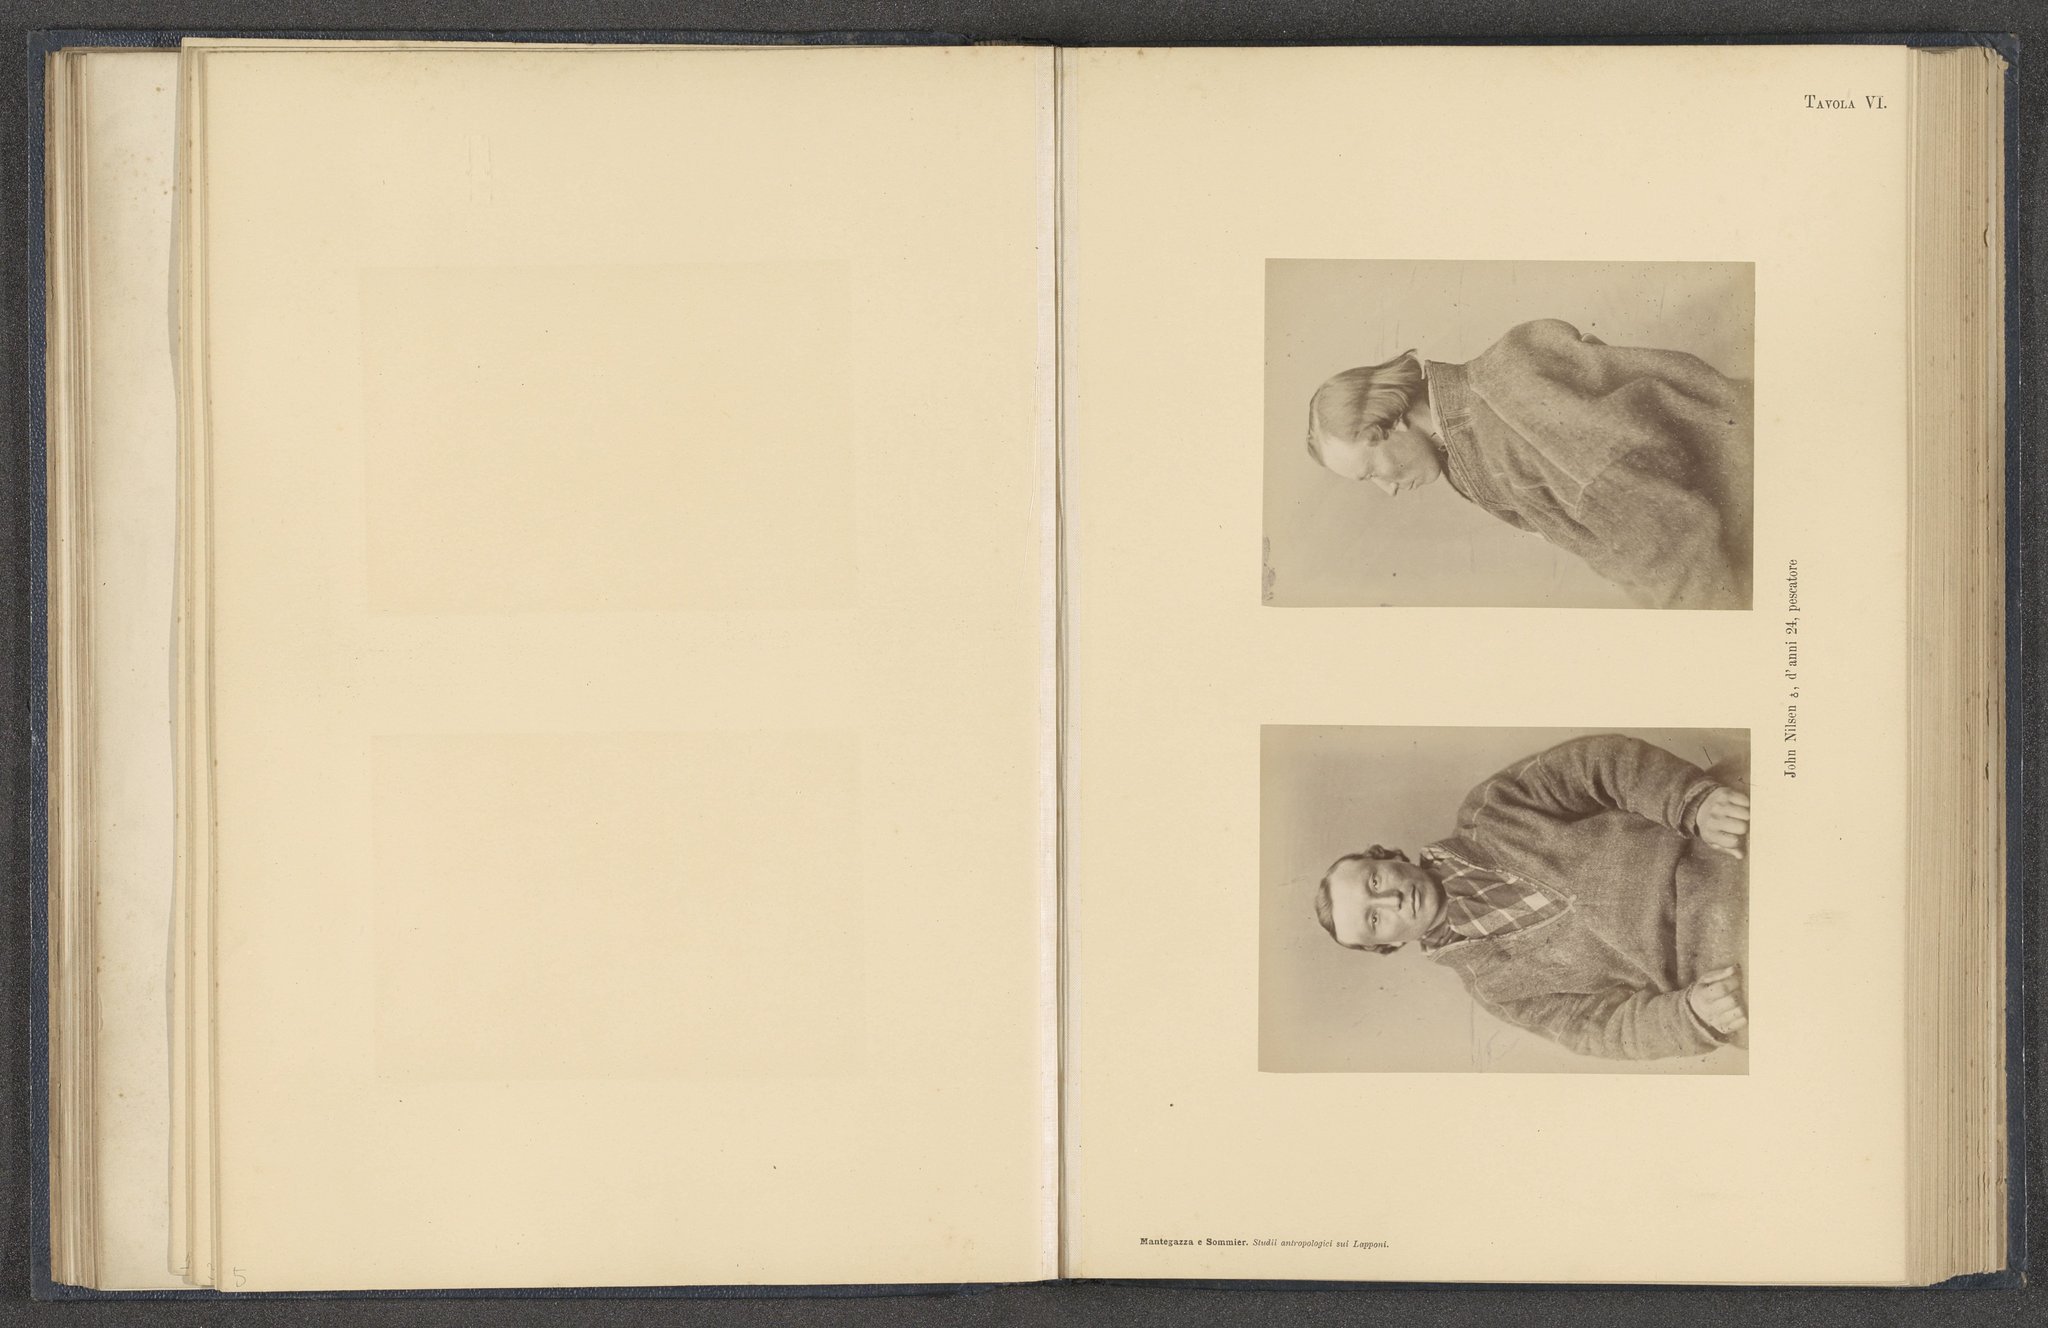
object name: page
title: John Nilsen ♂, d' anni 24, pescatore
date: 1870-1880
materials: paper, photographic support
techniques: albumen print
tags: adult man (+ front view), adult man (+ sideview, profile)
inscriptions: number: ‘Tavola VI.’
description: Links een vooraanzicht, rechts een zijaanzicht.